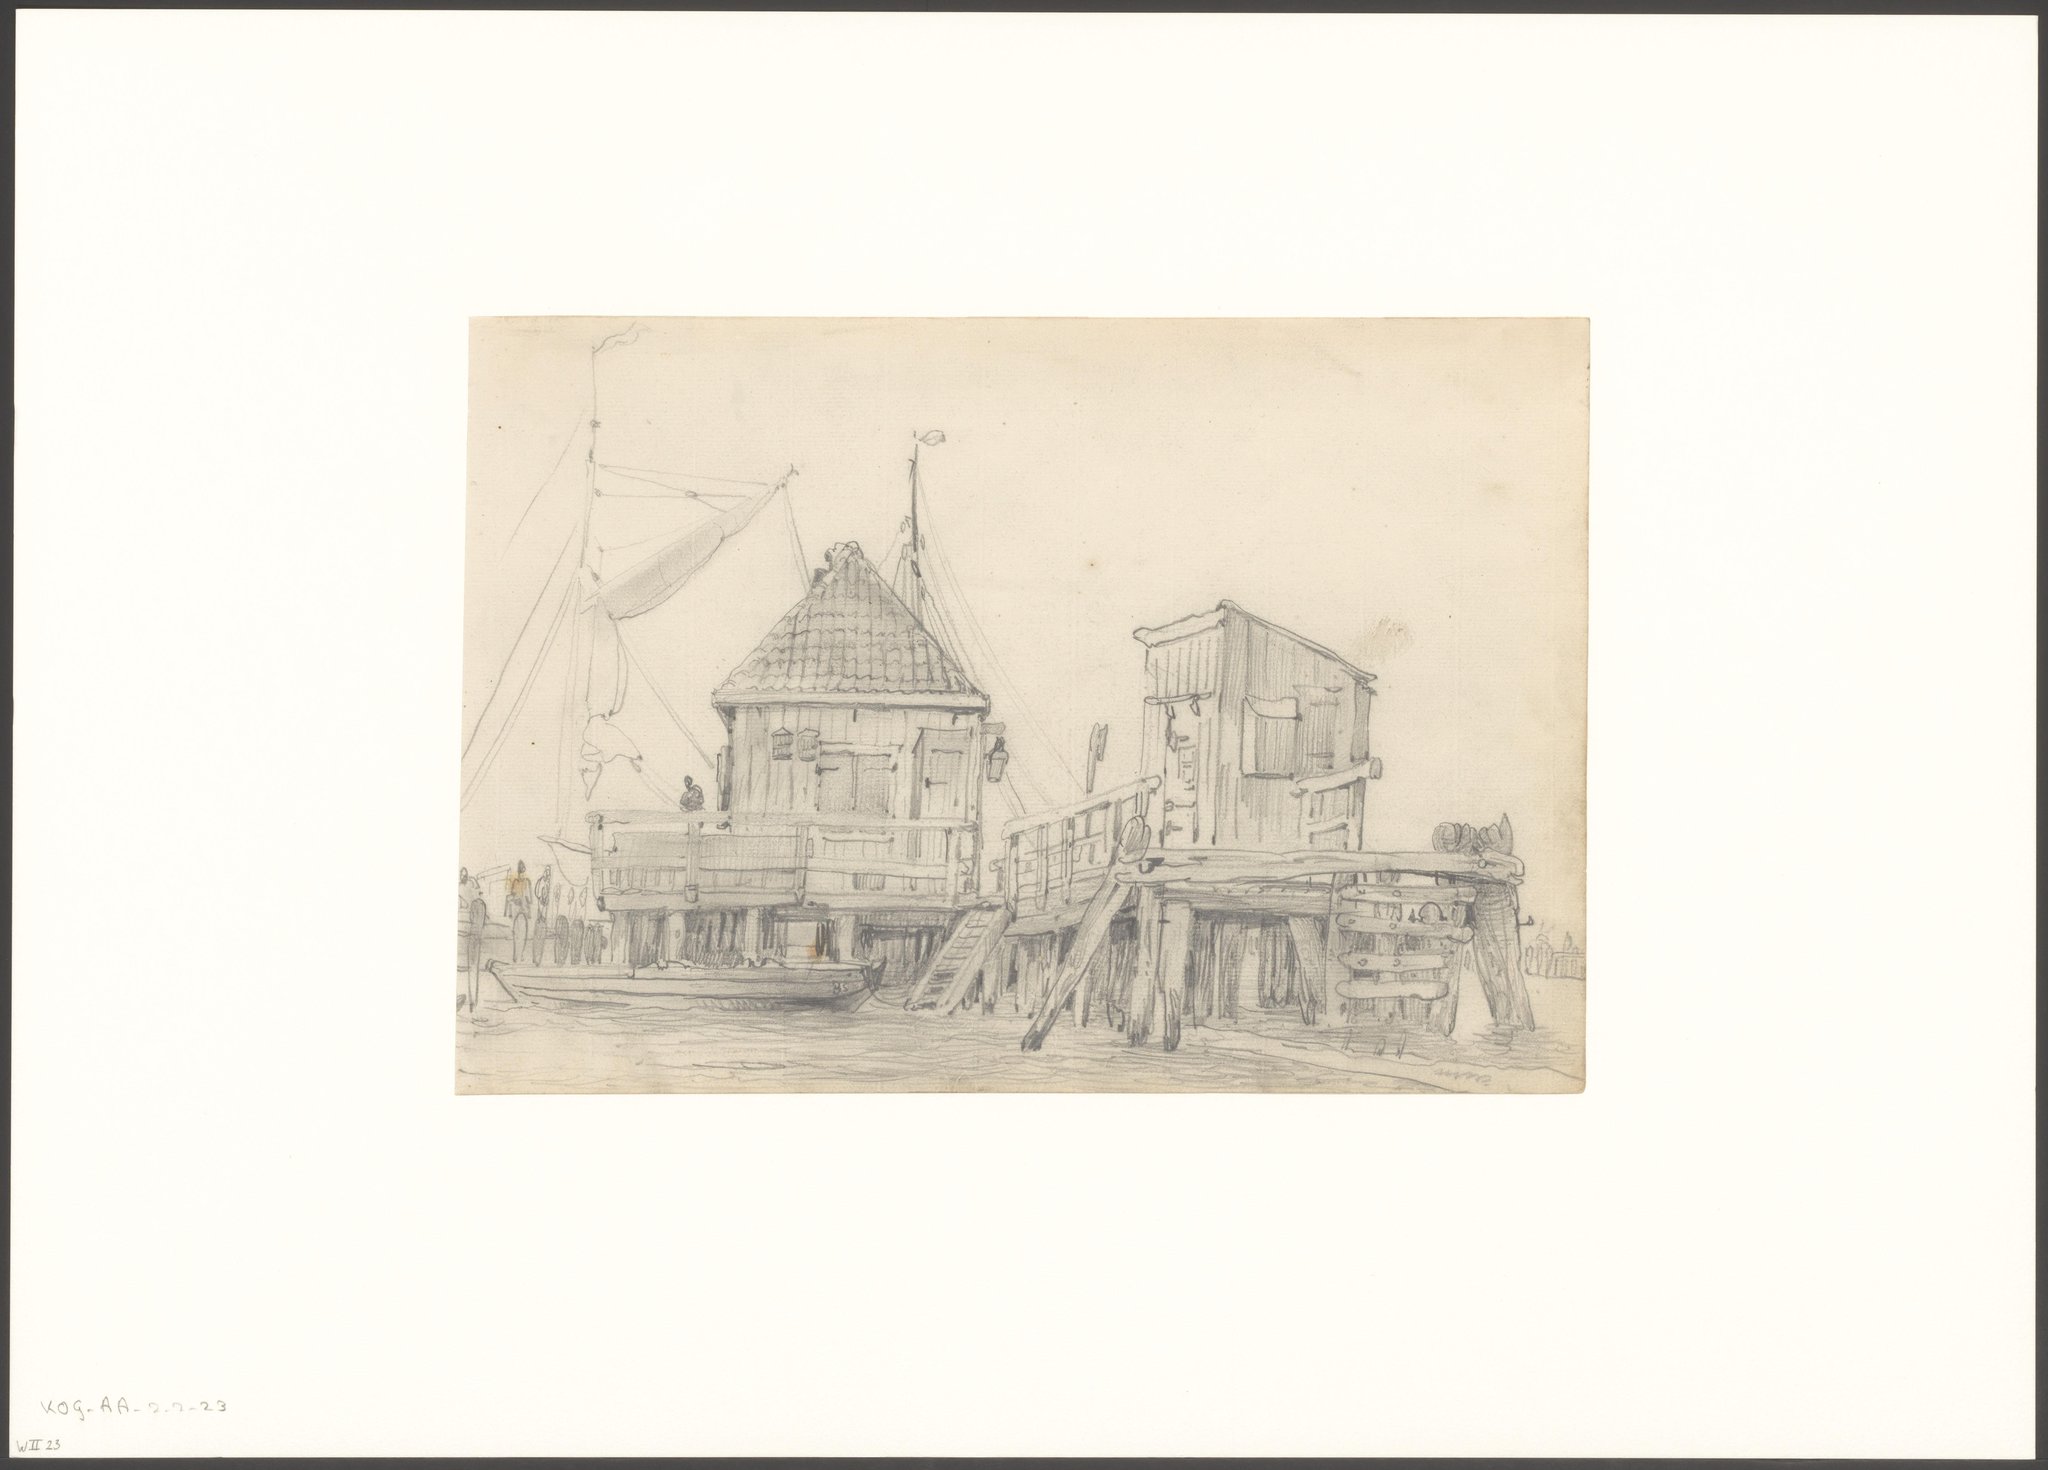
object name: drawing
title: Gezicht op het Bothuisje in het IJ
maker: willem anthonie van deventer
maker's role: draughtsman, painter, print maker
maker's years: 1824-1893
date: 1854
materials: paper, pencil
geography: amsterdam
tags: city-view in general; 'veduta', river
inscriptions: collector's mark: Lugt 800a, inscription: ‘W. Ant van Deventer / Kraan[...]’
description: Tekening binnen de Atlas Van Eck ingedeeld op wijknummer 2.